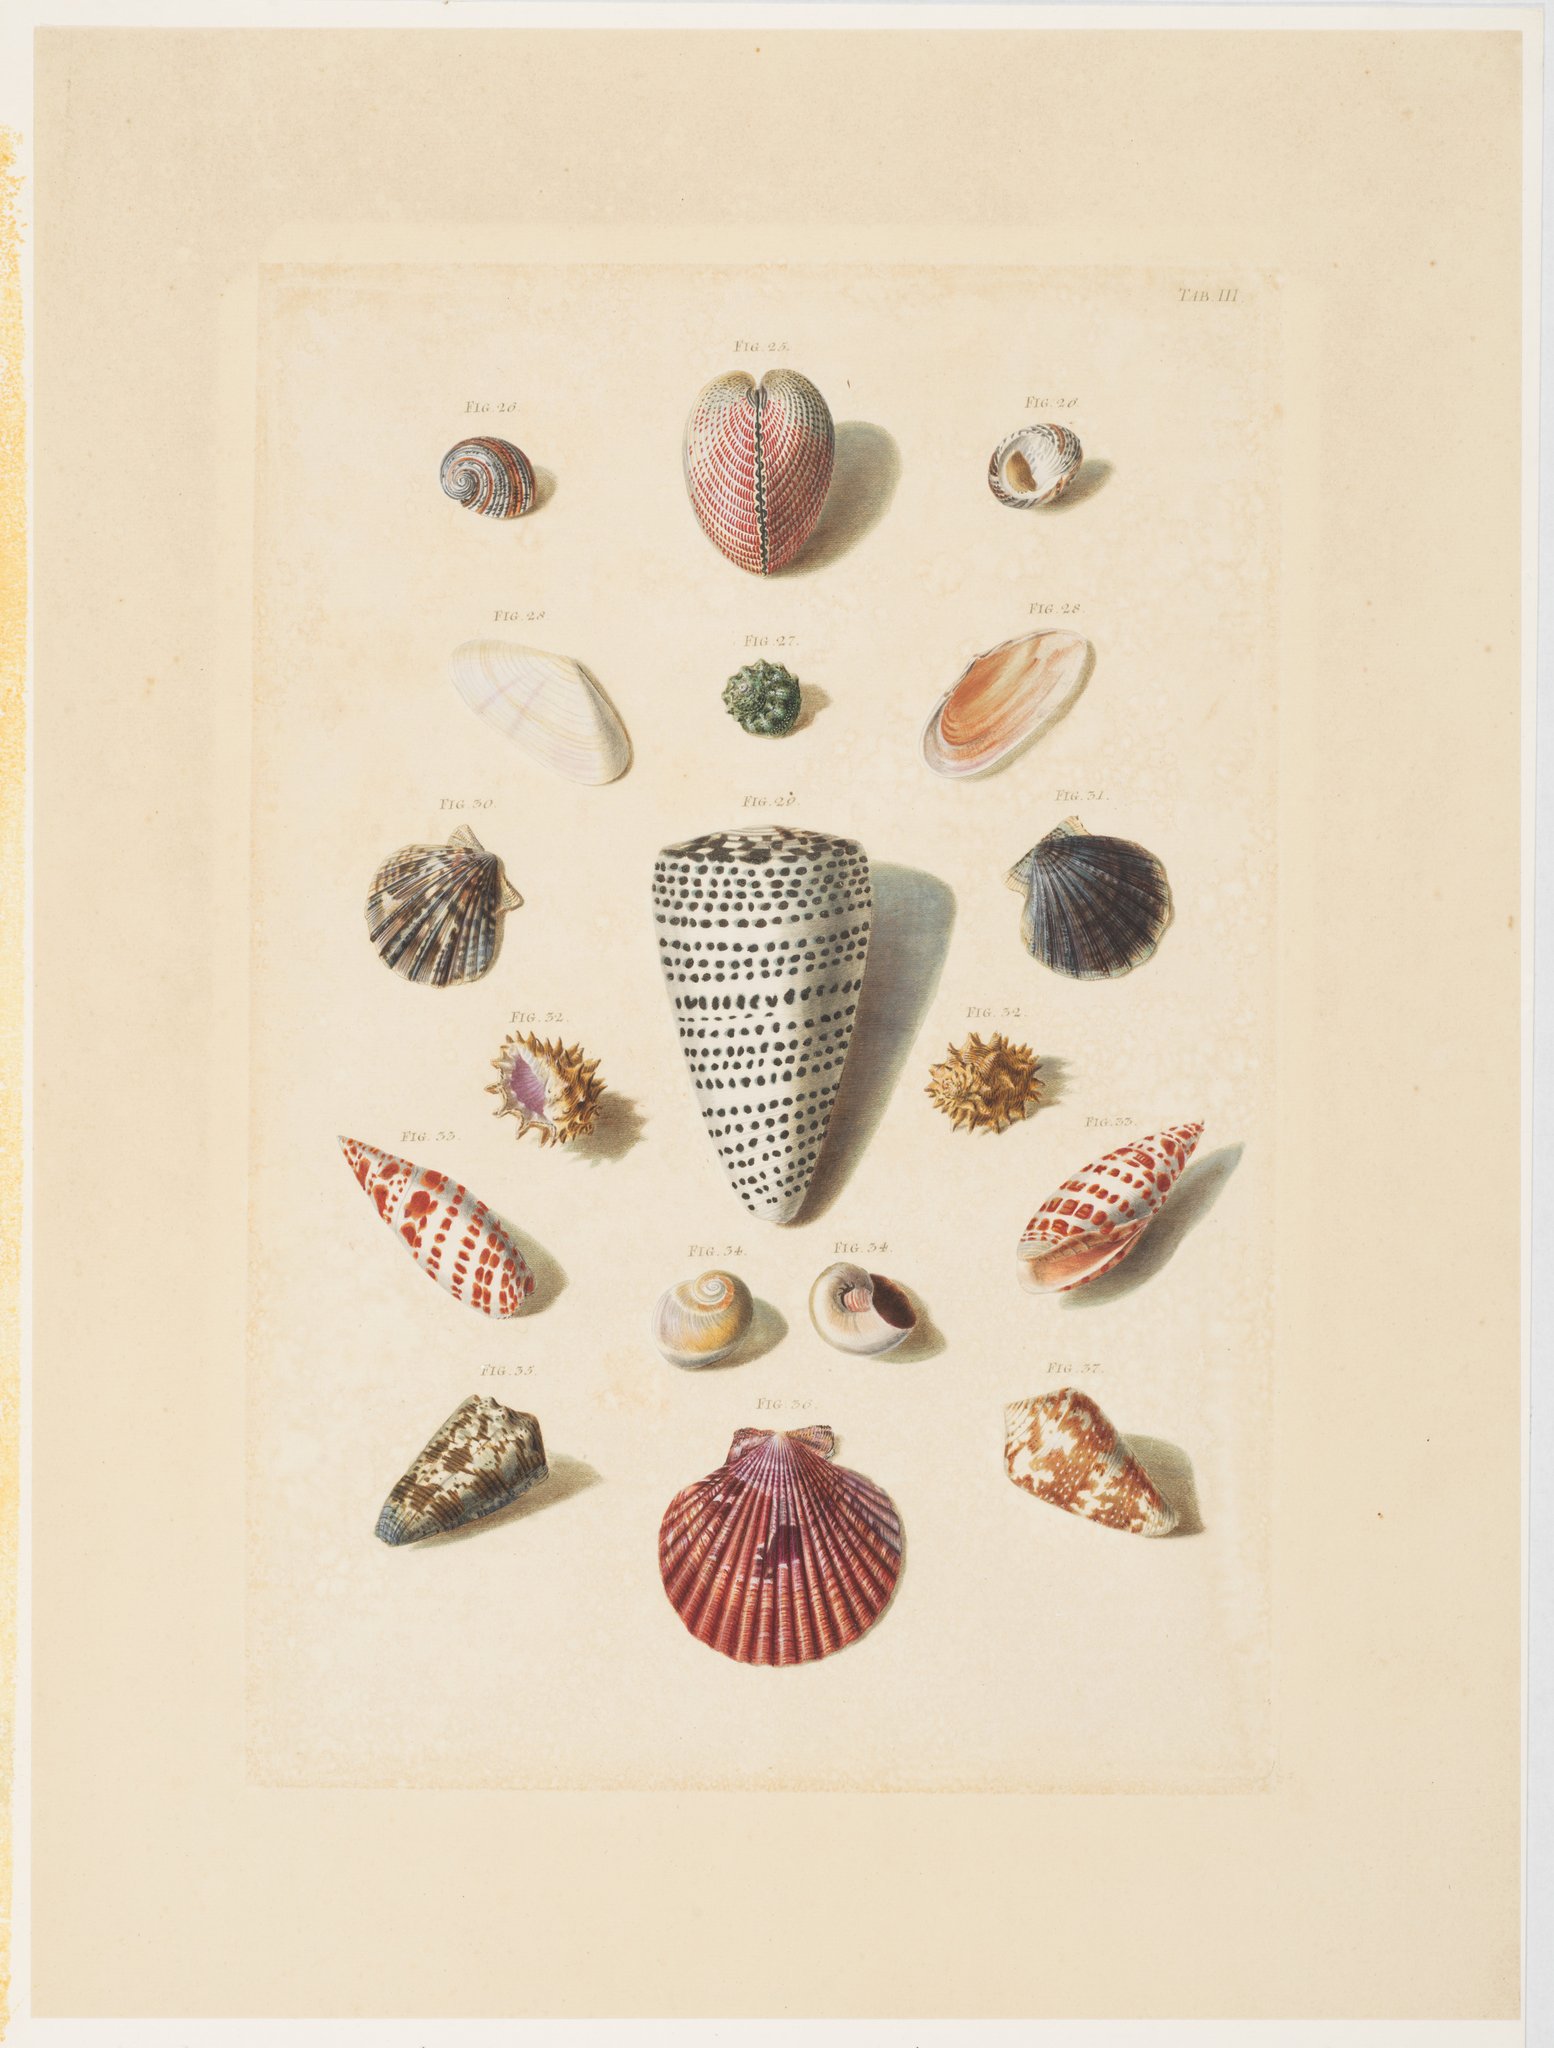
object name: print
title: Plate III, from "Choix de Coquillages et de Crustacés"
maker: franz michael regenfuss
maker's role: artist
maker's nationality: german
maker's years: 1707-1780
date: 1758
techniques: engraving, hand coloring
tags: shells